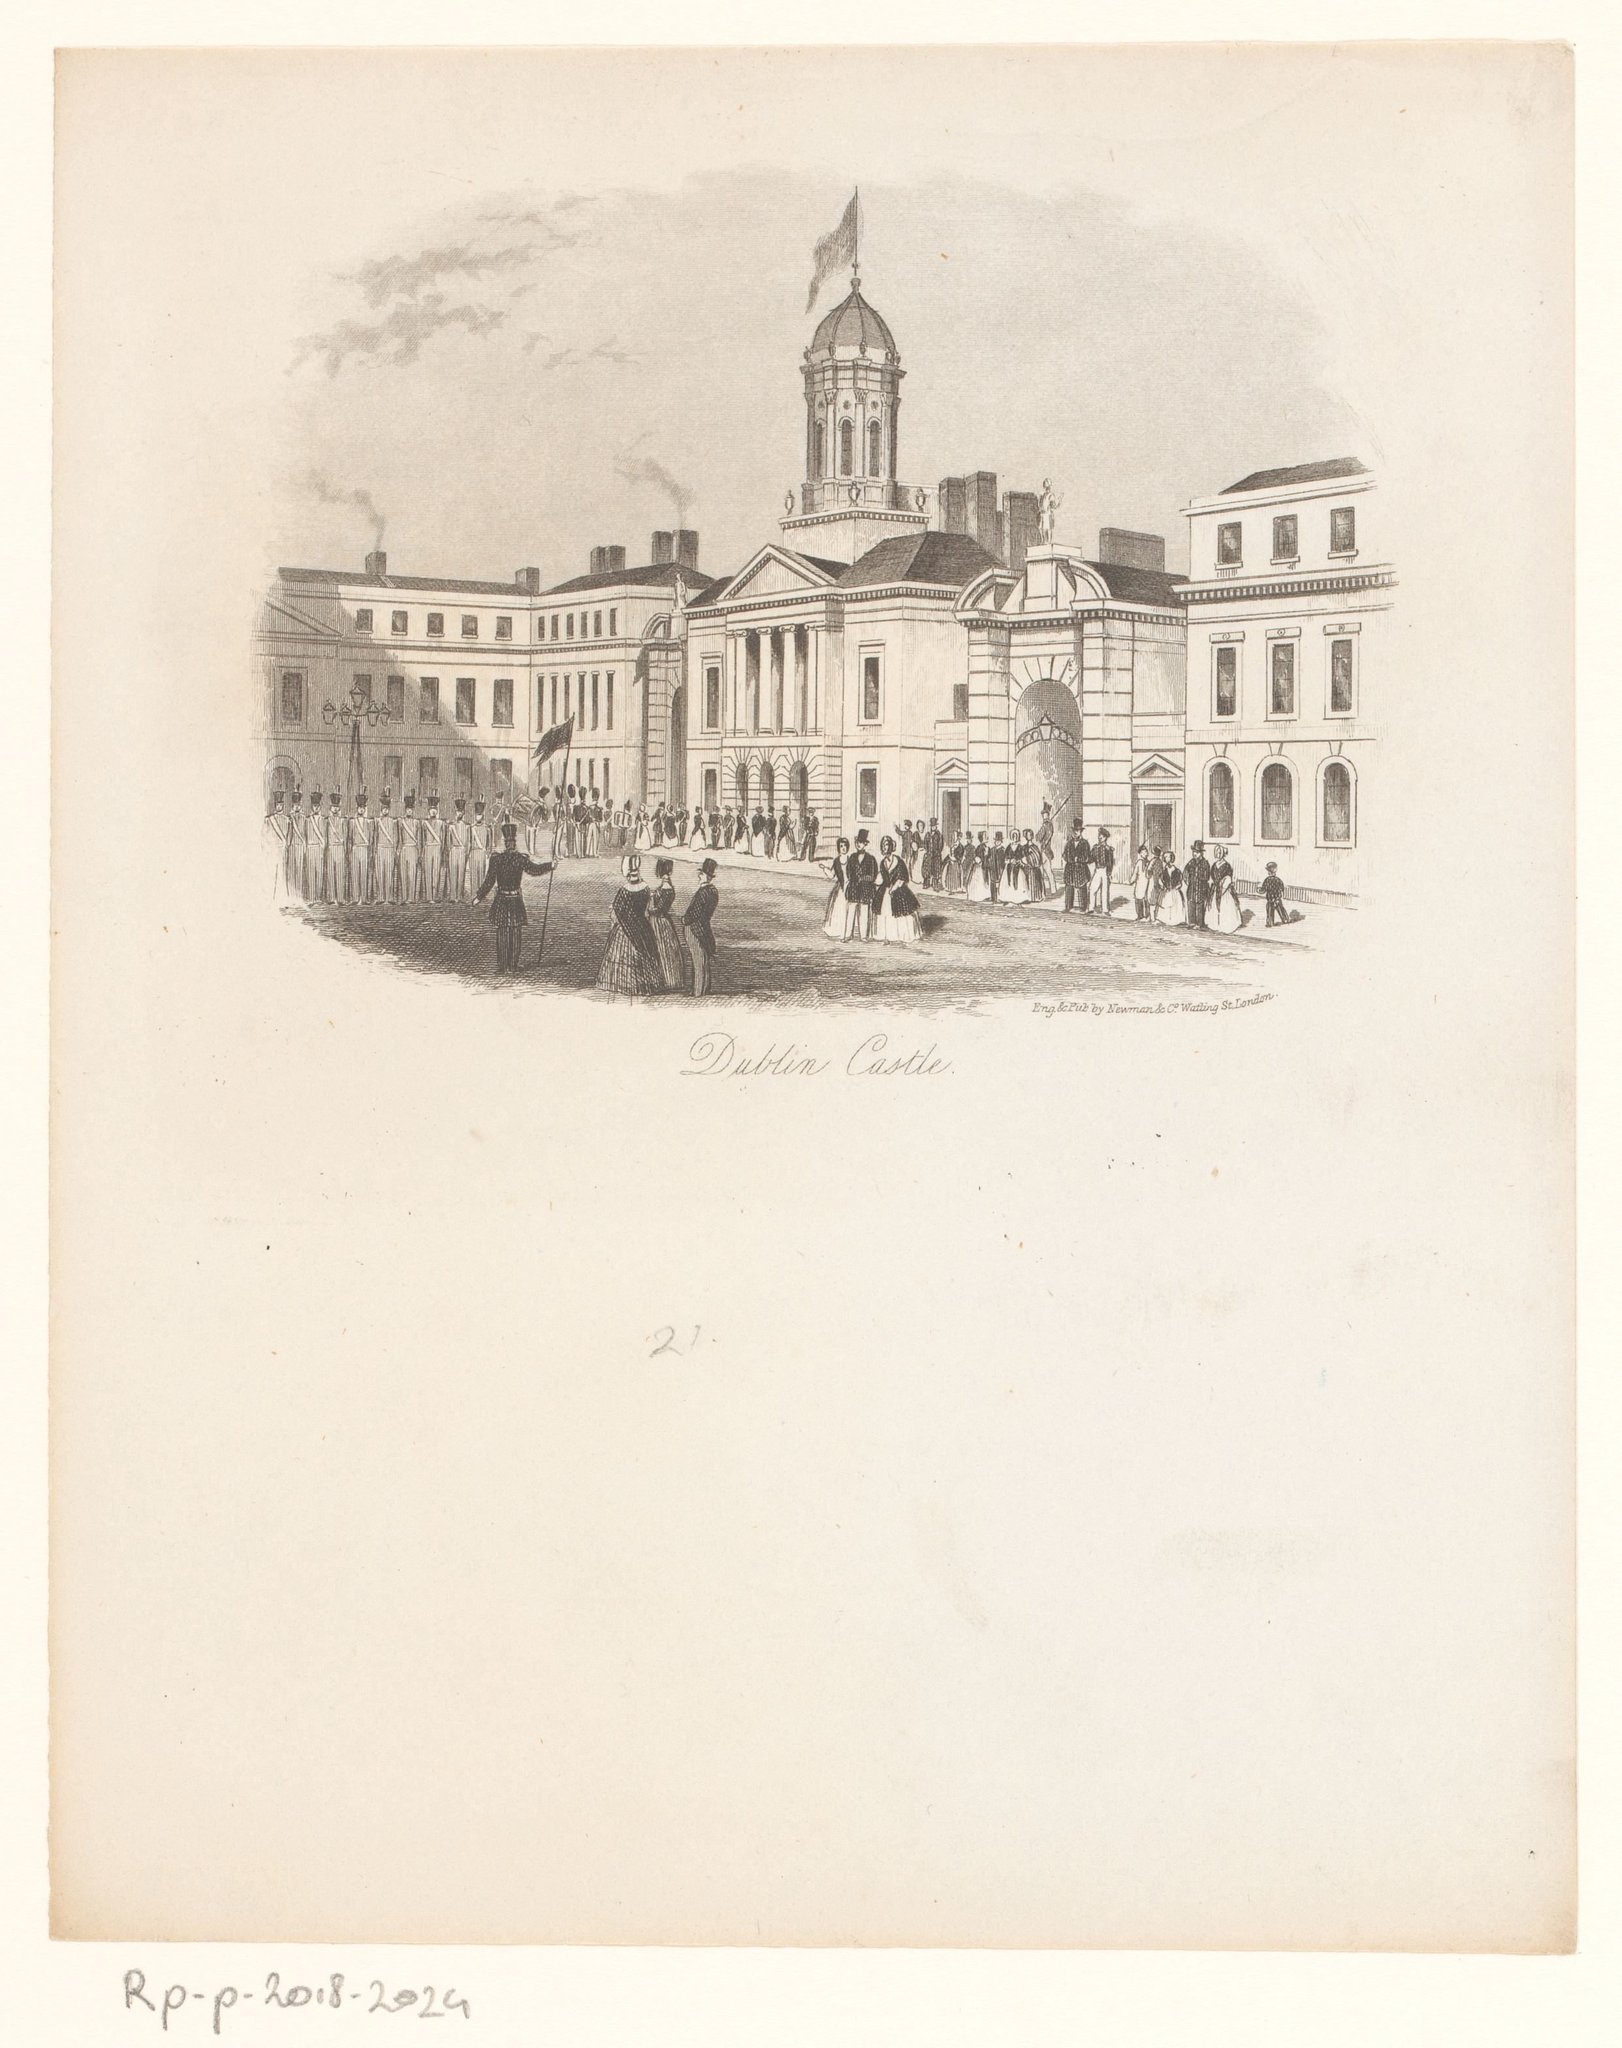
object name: print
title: Dublin Castle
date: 1848-1874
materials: paper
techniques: etching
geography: london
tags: castle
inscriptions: collector's mark: Lugt 2228